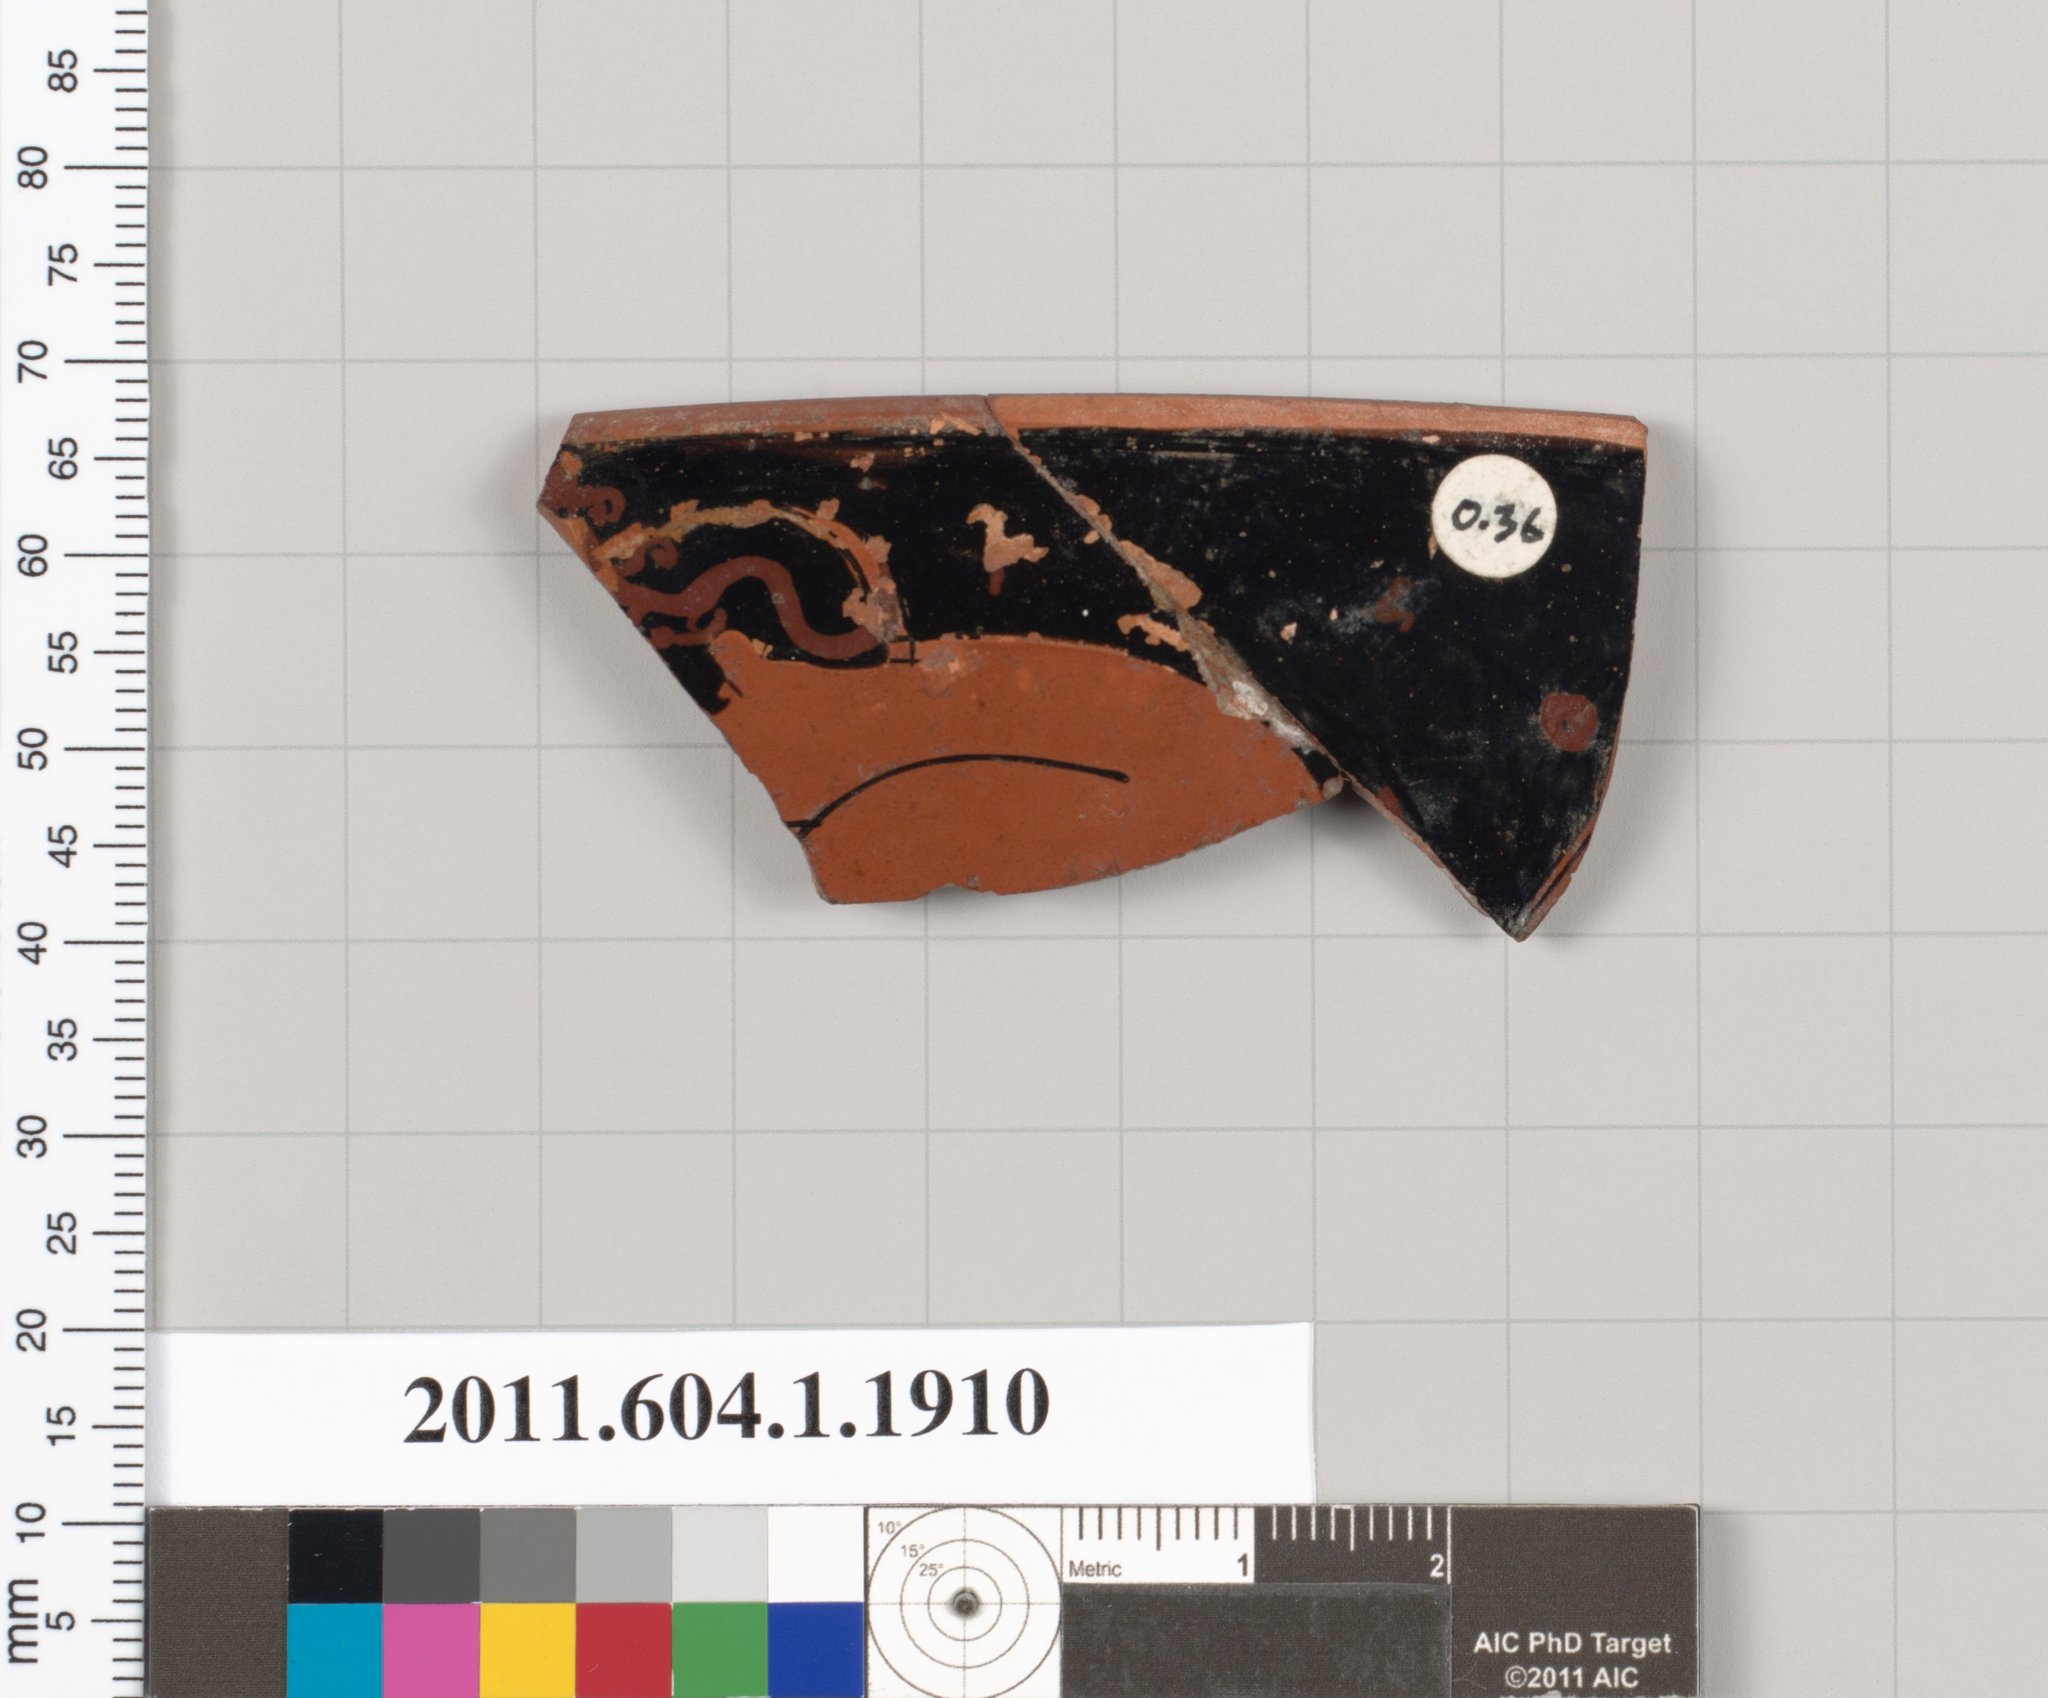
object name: kylix fragment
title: Terracotta rim fragment of a kylix (drinking cup)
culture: greek, attic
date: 534-468 BCE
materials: terracotta